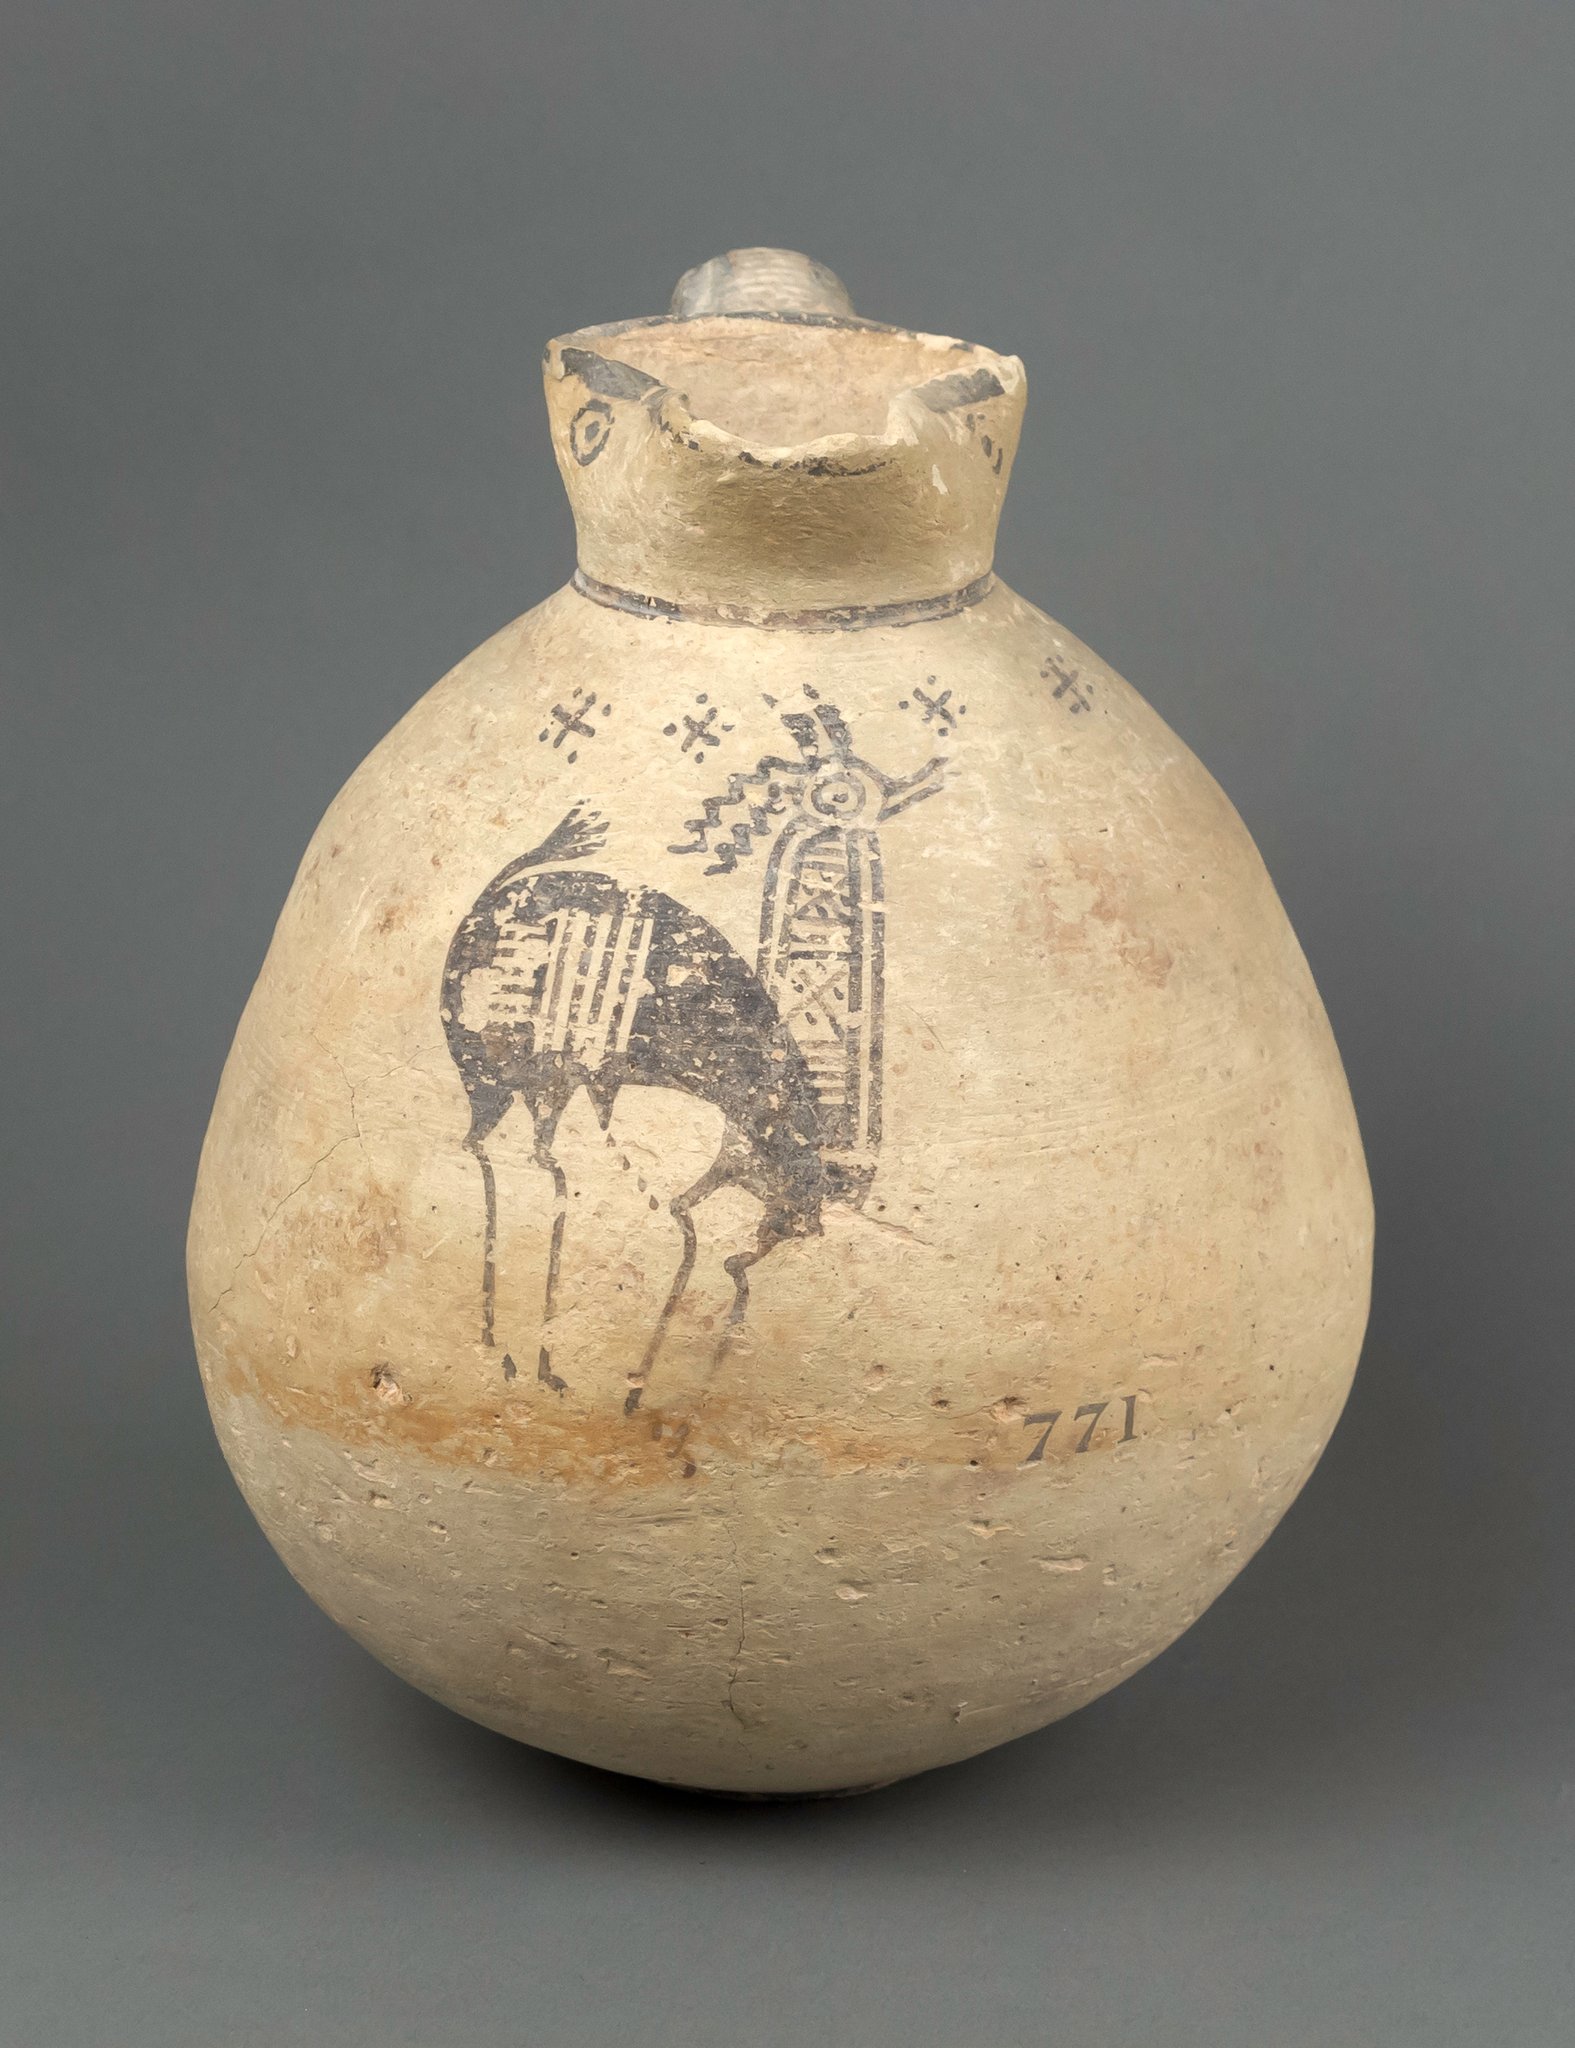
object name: juglet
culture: cypriot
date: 750-600 BCE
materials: terracotta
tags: animals